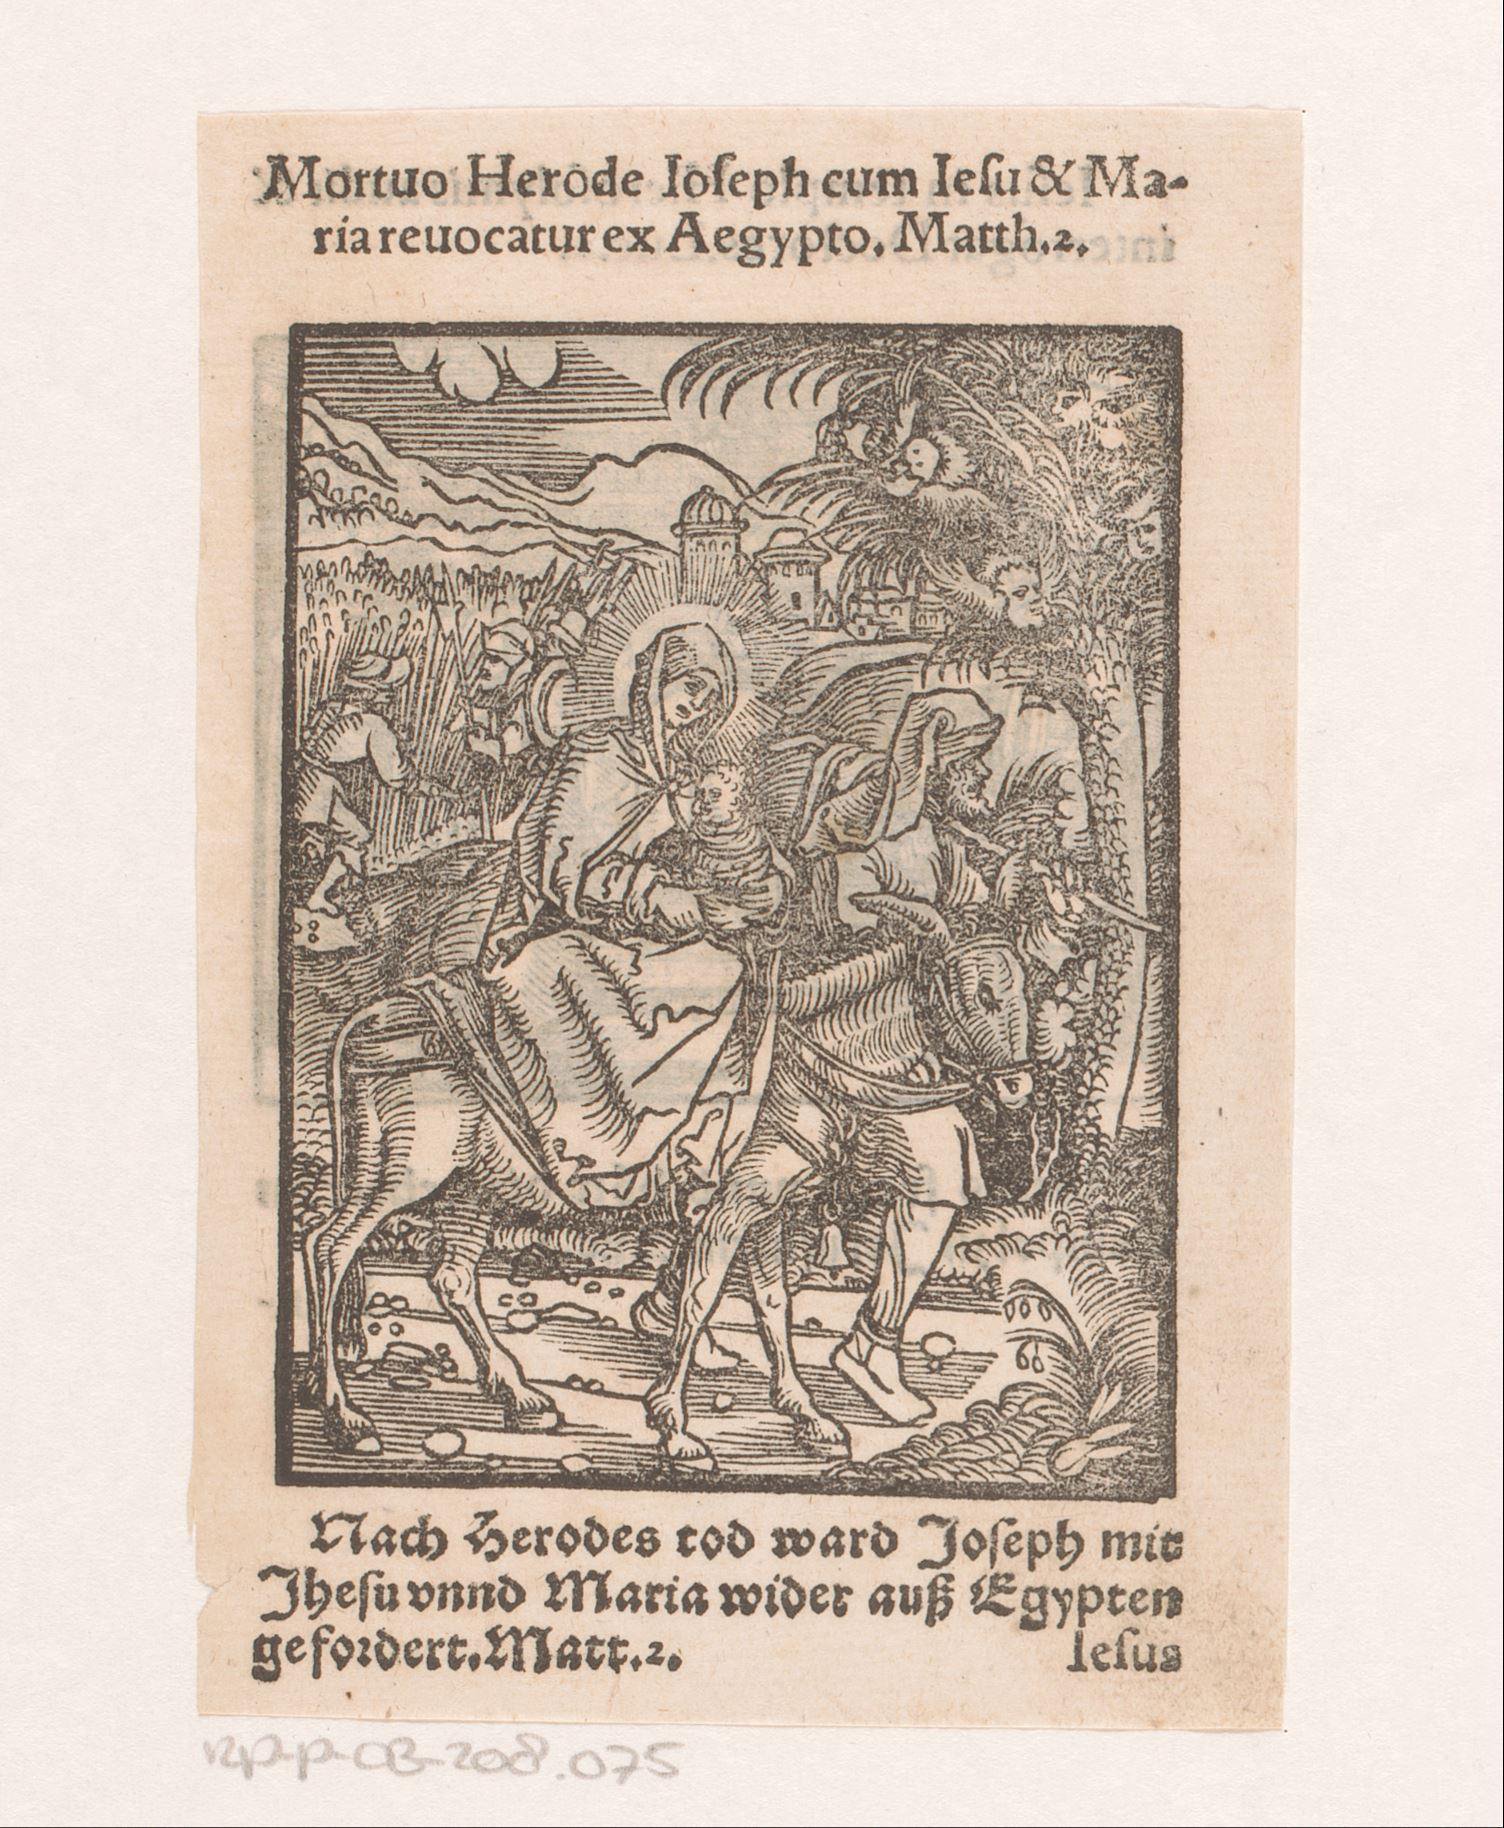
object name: print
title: Vlucht naar Egypte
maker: Anonymous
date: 1600-1699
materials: paper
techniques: letterpress printing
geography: netherlands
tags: the flight into egypt: mary, joseph, the child (and sometimes others) on their way; mary usually riding on an ass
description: De Heilige Familie vlucht naar Egypte. Maria zit met het Christuskind op de ezel, die wordt geleid door Jozef.